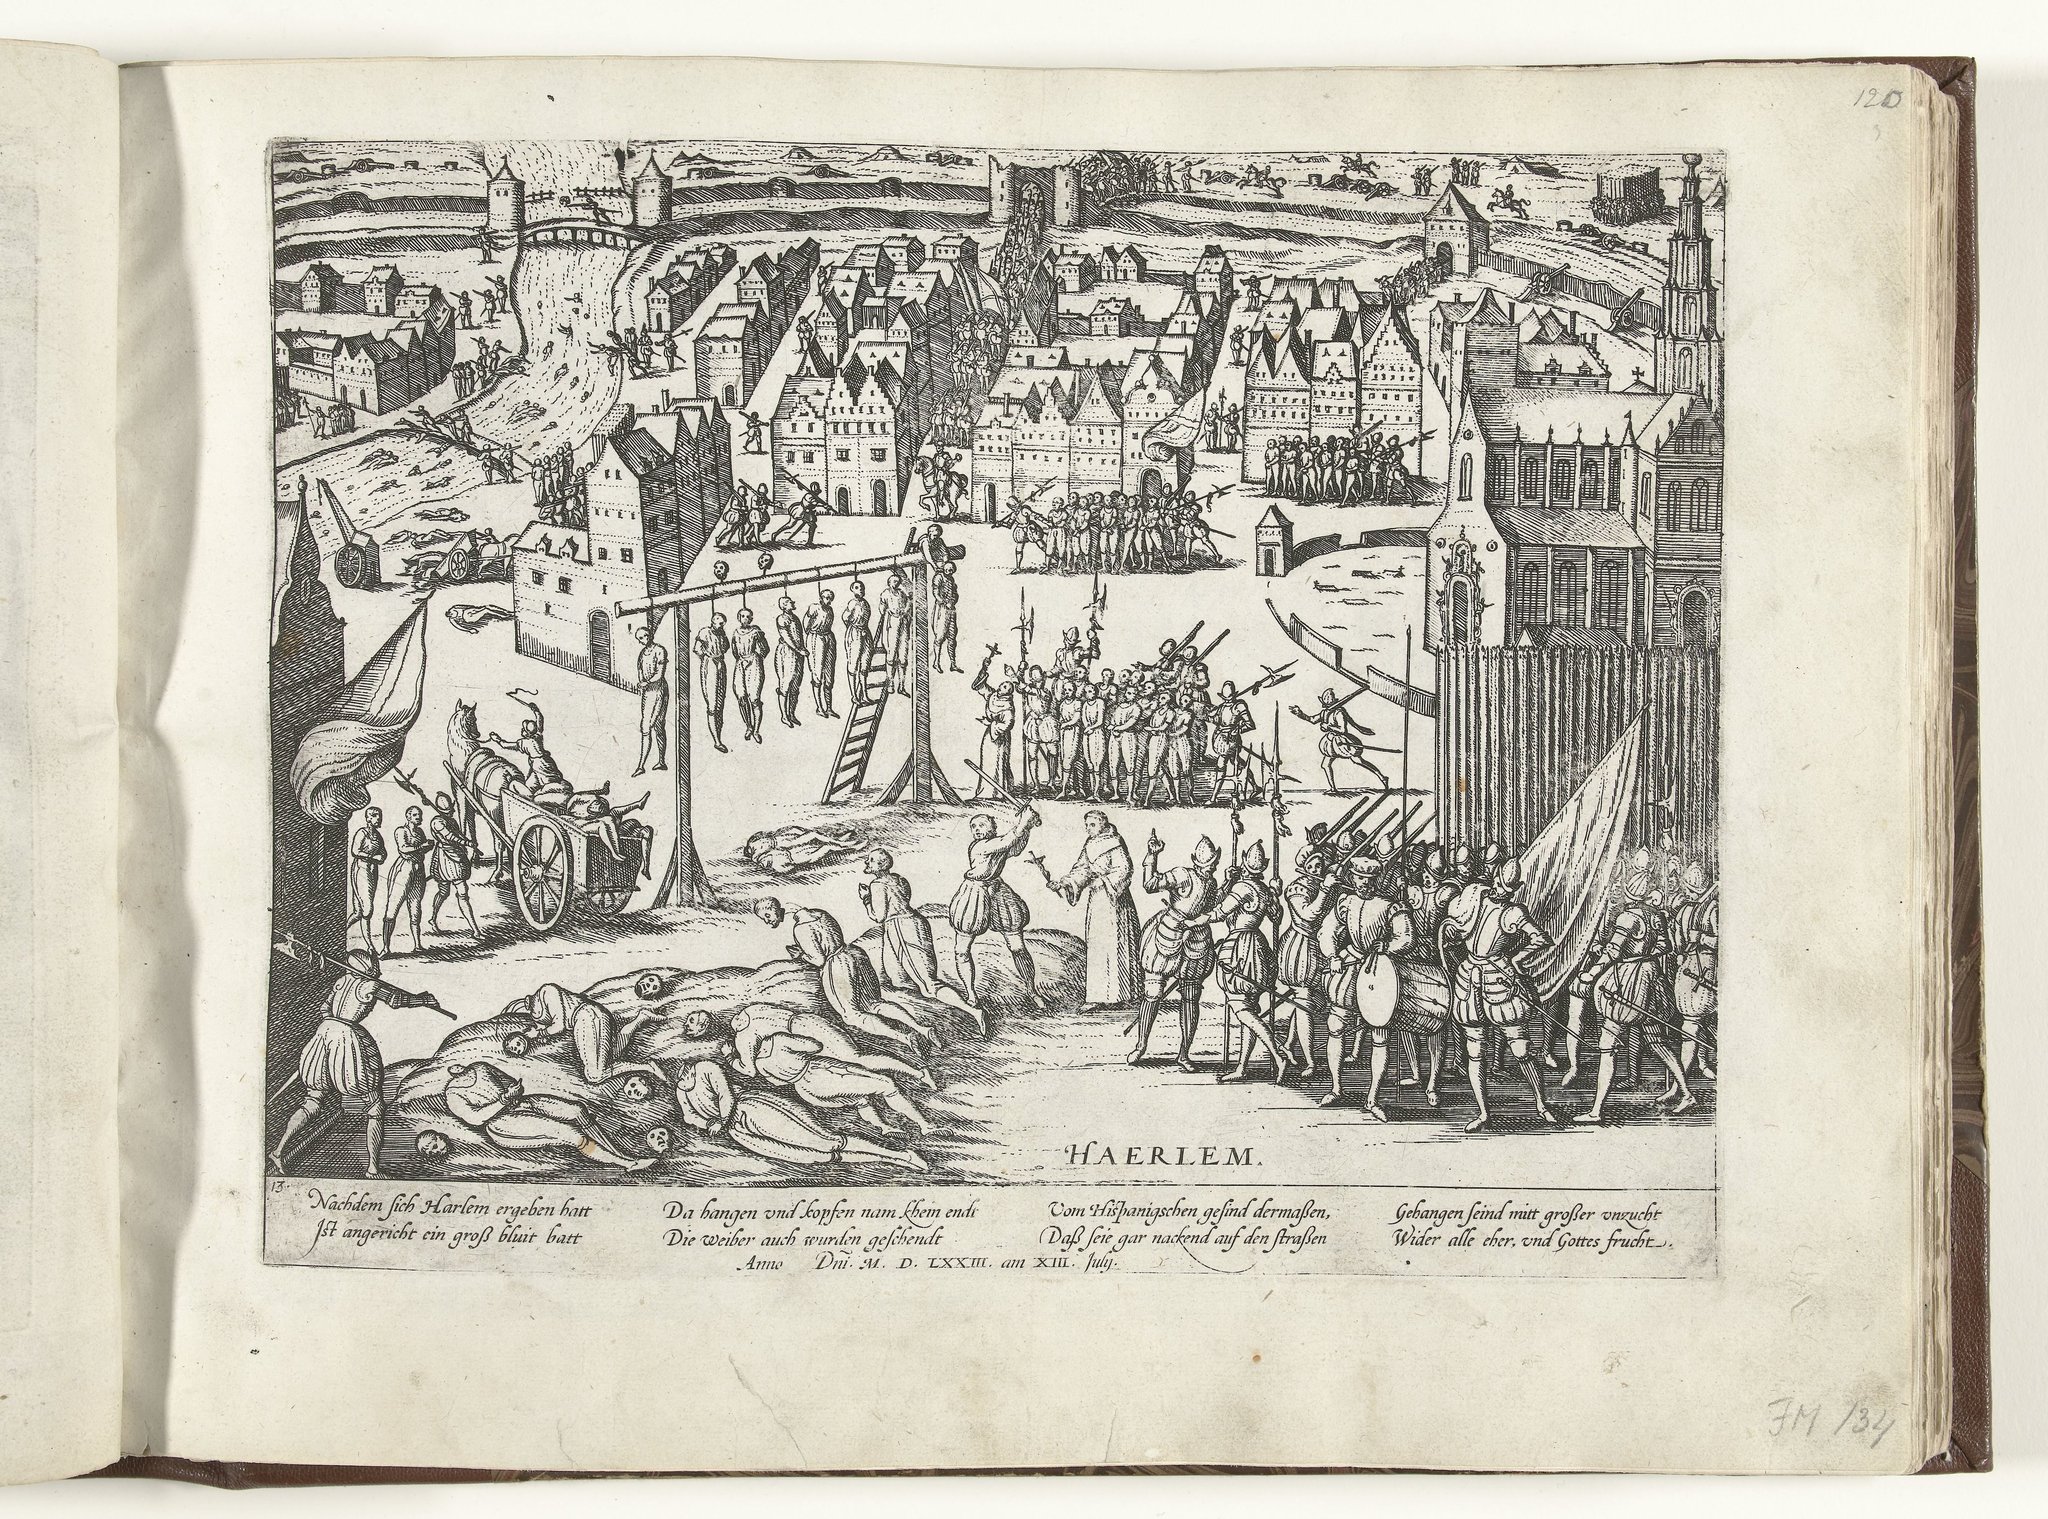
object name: album leaf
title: Moord te Haarlem door de Spanjaarden, 1573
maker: frans hogenberg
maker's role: print maker, publisher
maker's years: 1538-1590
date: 1573-1575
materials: paper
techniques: etching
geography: cologne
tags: violent death by hanging, massacre ~ war, violent death by beheading, haarlem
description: Terechtstelling en moord op de verdedigers van Haarlem door Spaanse soldaten onder Don Frederik, na de overgave van de stad op 13 juli 1573. Op de voorgrond onthoofdingen en ophangingen, links worden lichamen in een kar afgevoerd. Op de achtergrond worden anderen in het water verdronken. Met onderschrift van 8 regels in het Duits. Genummerd: 13.